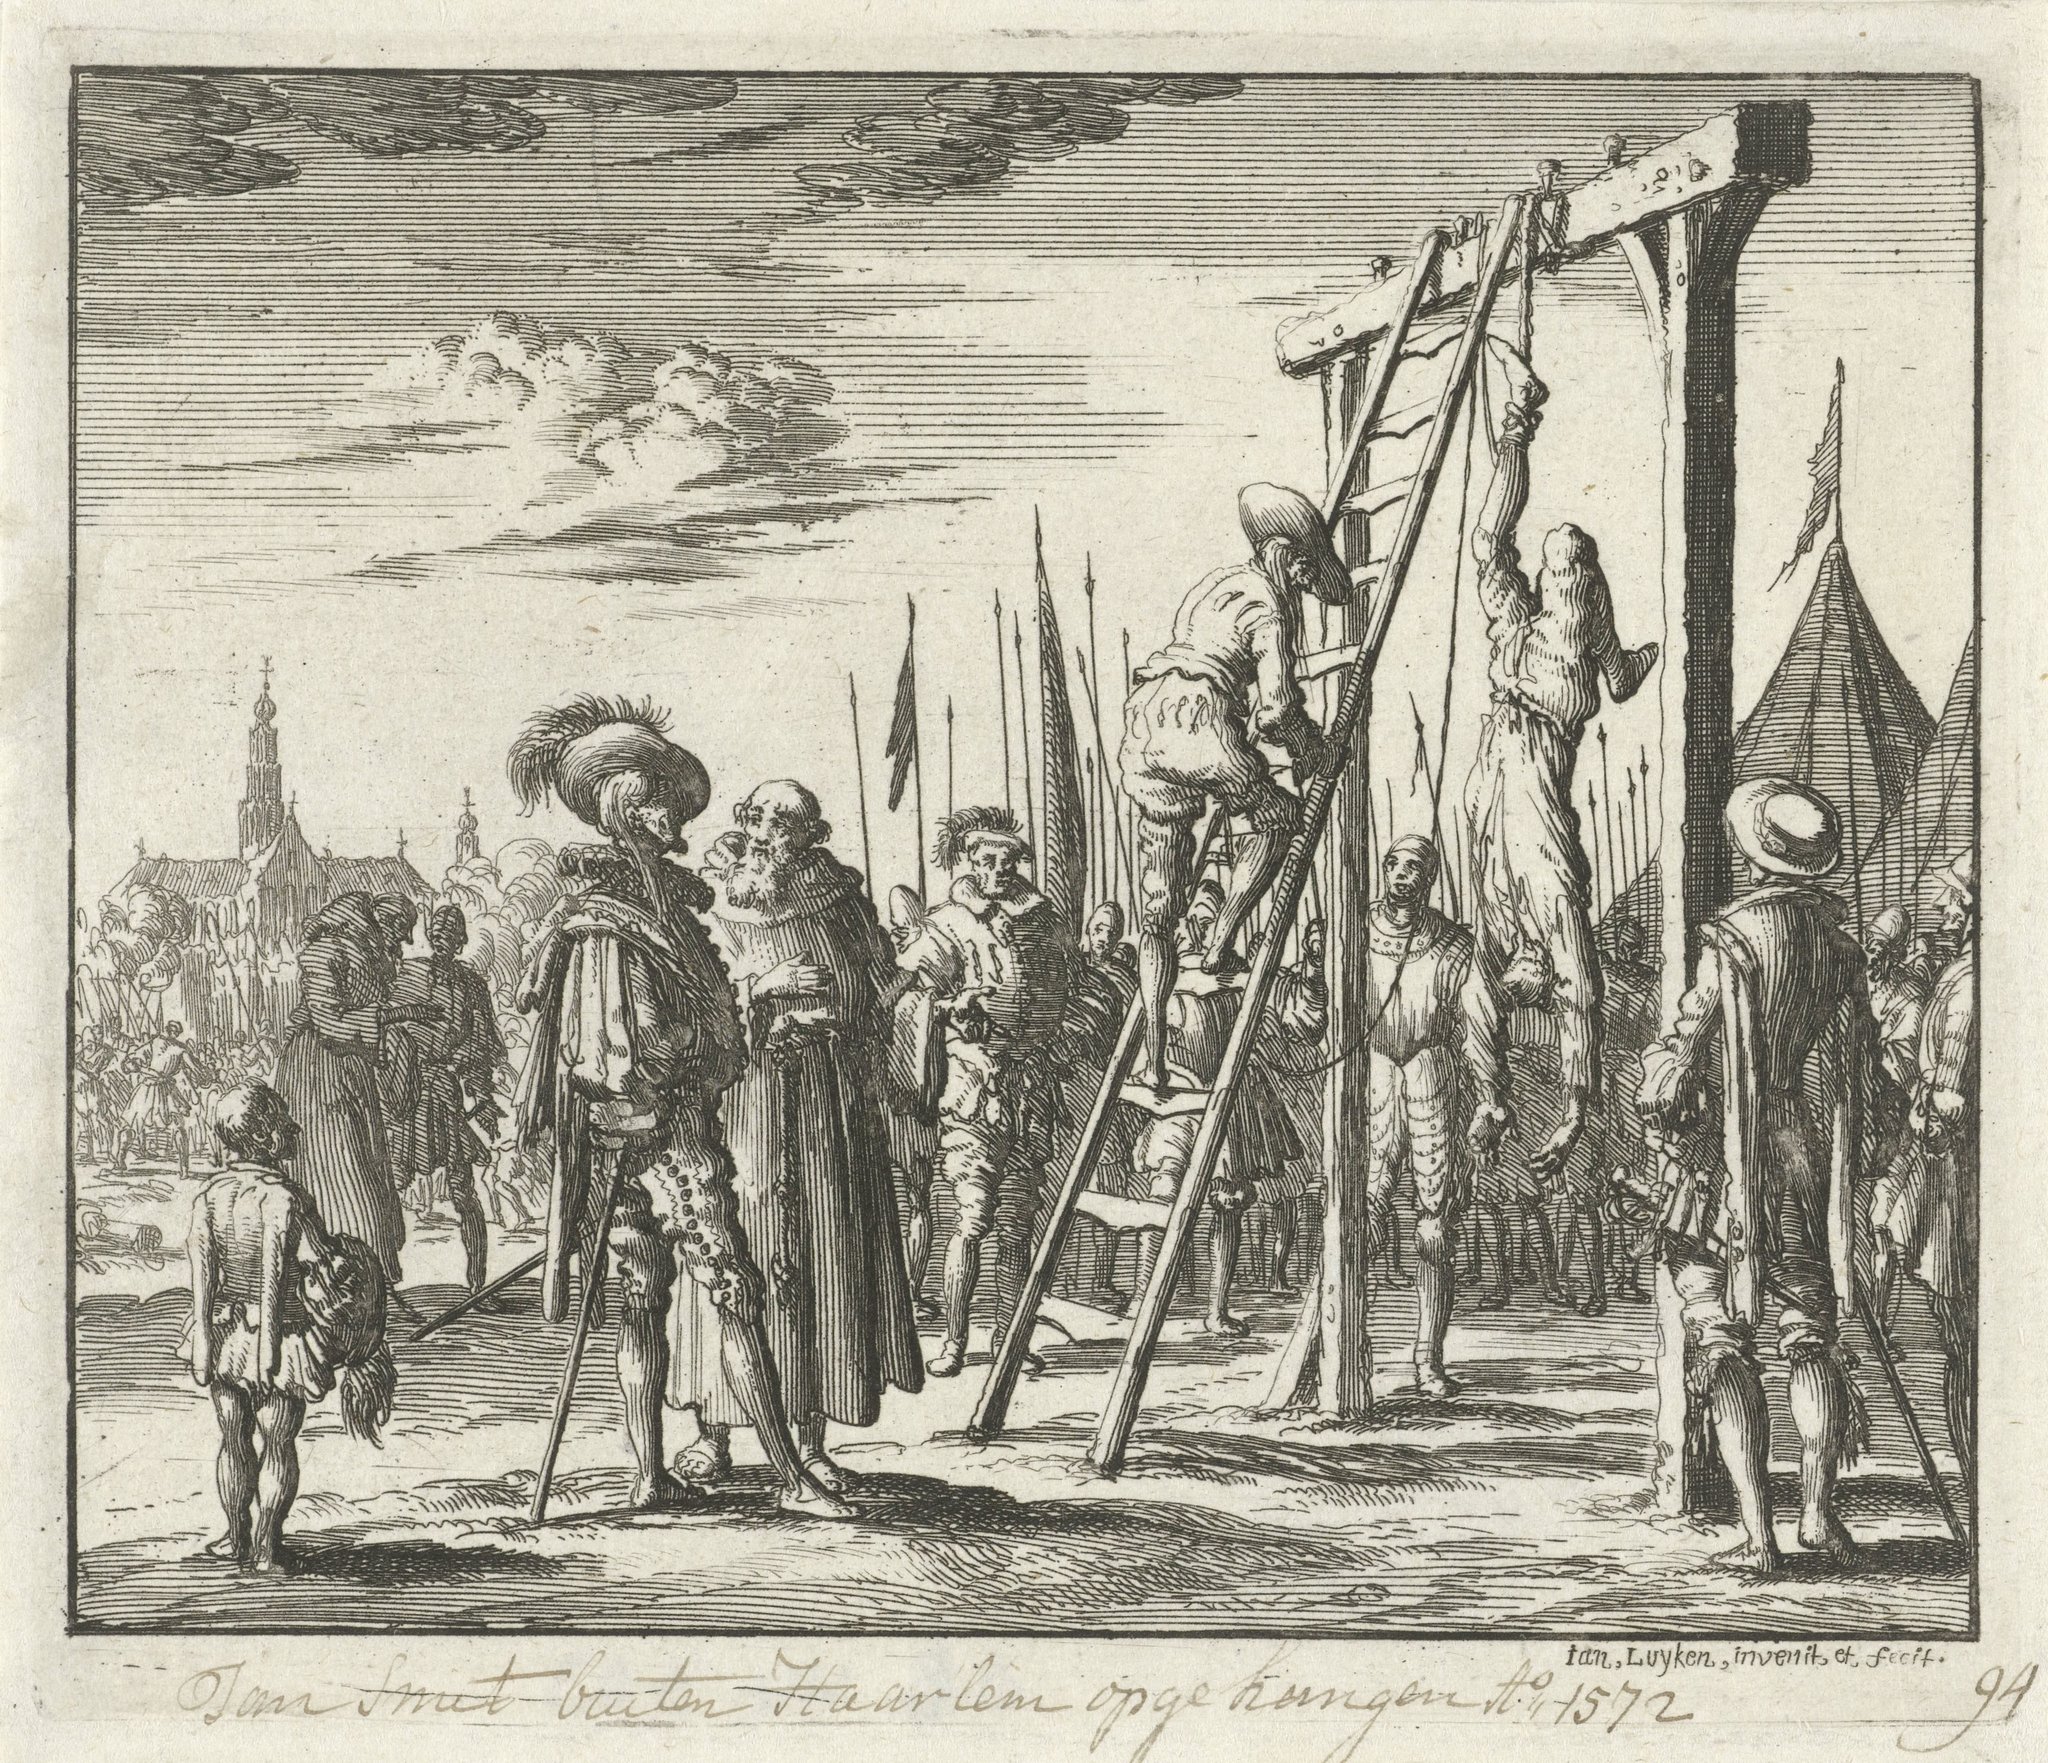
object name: book illustration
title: Jan Smit te Haarlem aan één been opgehangen, 1572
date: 1685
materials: paper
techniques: etching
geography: amsterdam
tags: execution of heretic, e.g. by burning at the stake, 'auto-da-fé', haarlem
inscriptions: inscription: ‘Jan Smit [...] Ao 1572’, collector's mark: Lugt 2228, number: ‘94’